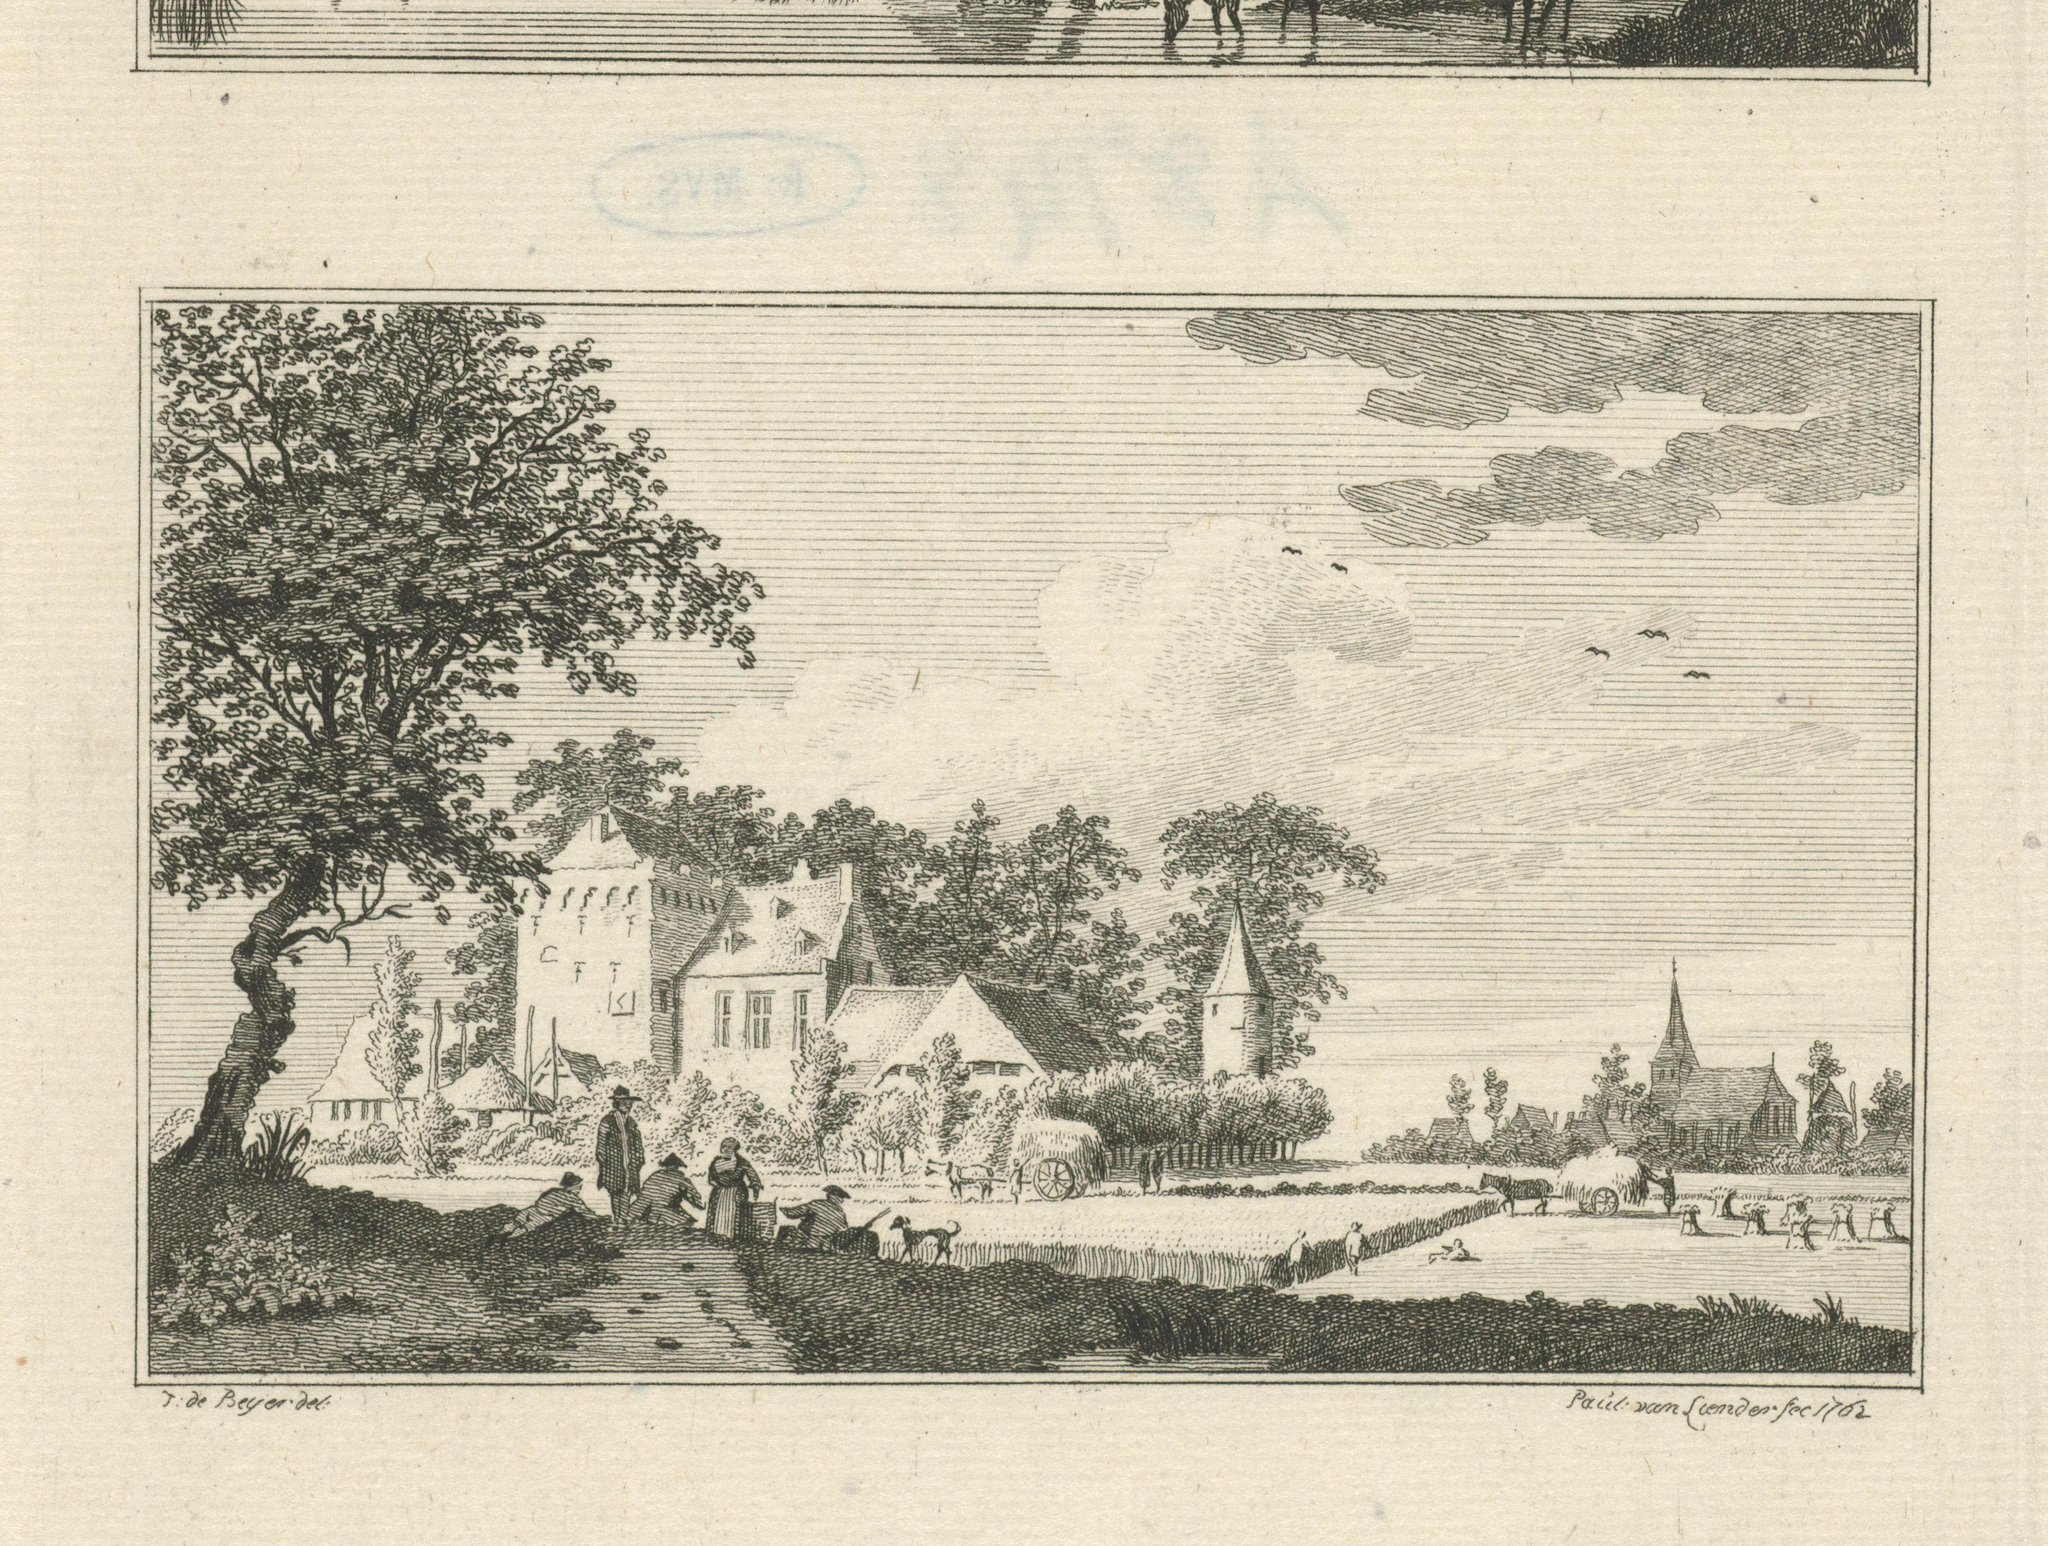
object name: print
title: Dorps- en stadsgezichten te Kleef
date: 1762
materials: paper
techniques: etching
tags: rural housing, e.g. country-house, villa, cottage, village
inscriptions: collector's mark: Lugt 2228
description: Twee voorstellingen van één plaat. Gezichten op het Kasteel Poelwijk in Oud Zevenaar (boven) en het Huis Rijswijk te Groessen (onder). De prent maakt deel uit van een 100-delige serie met gezichten op dorpen en steden te Kleef.